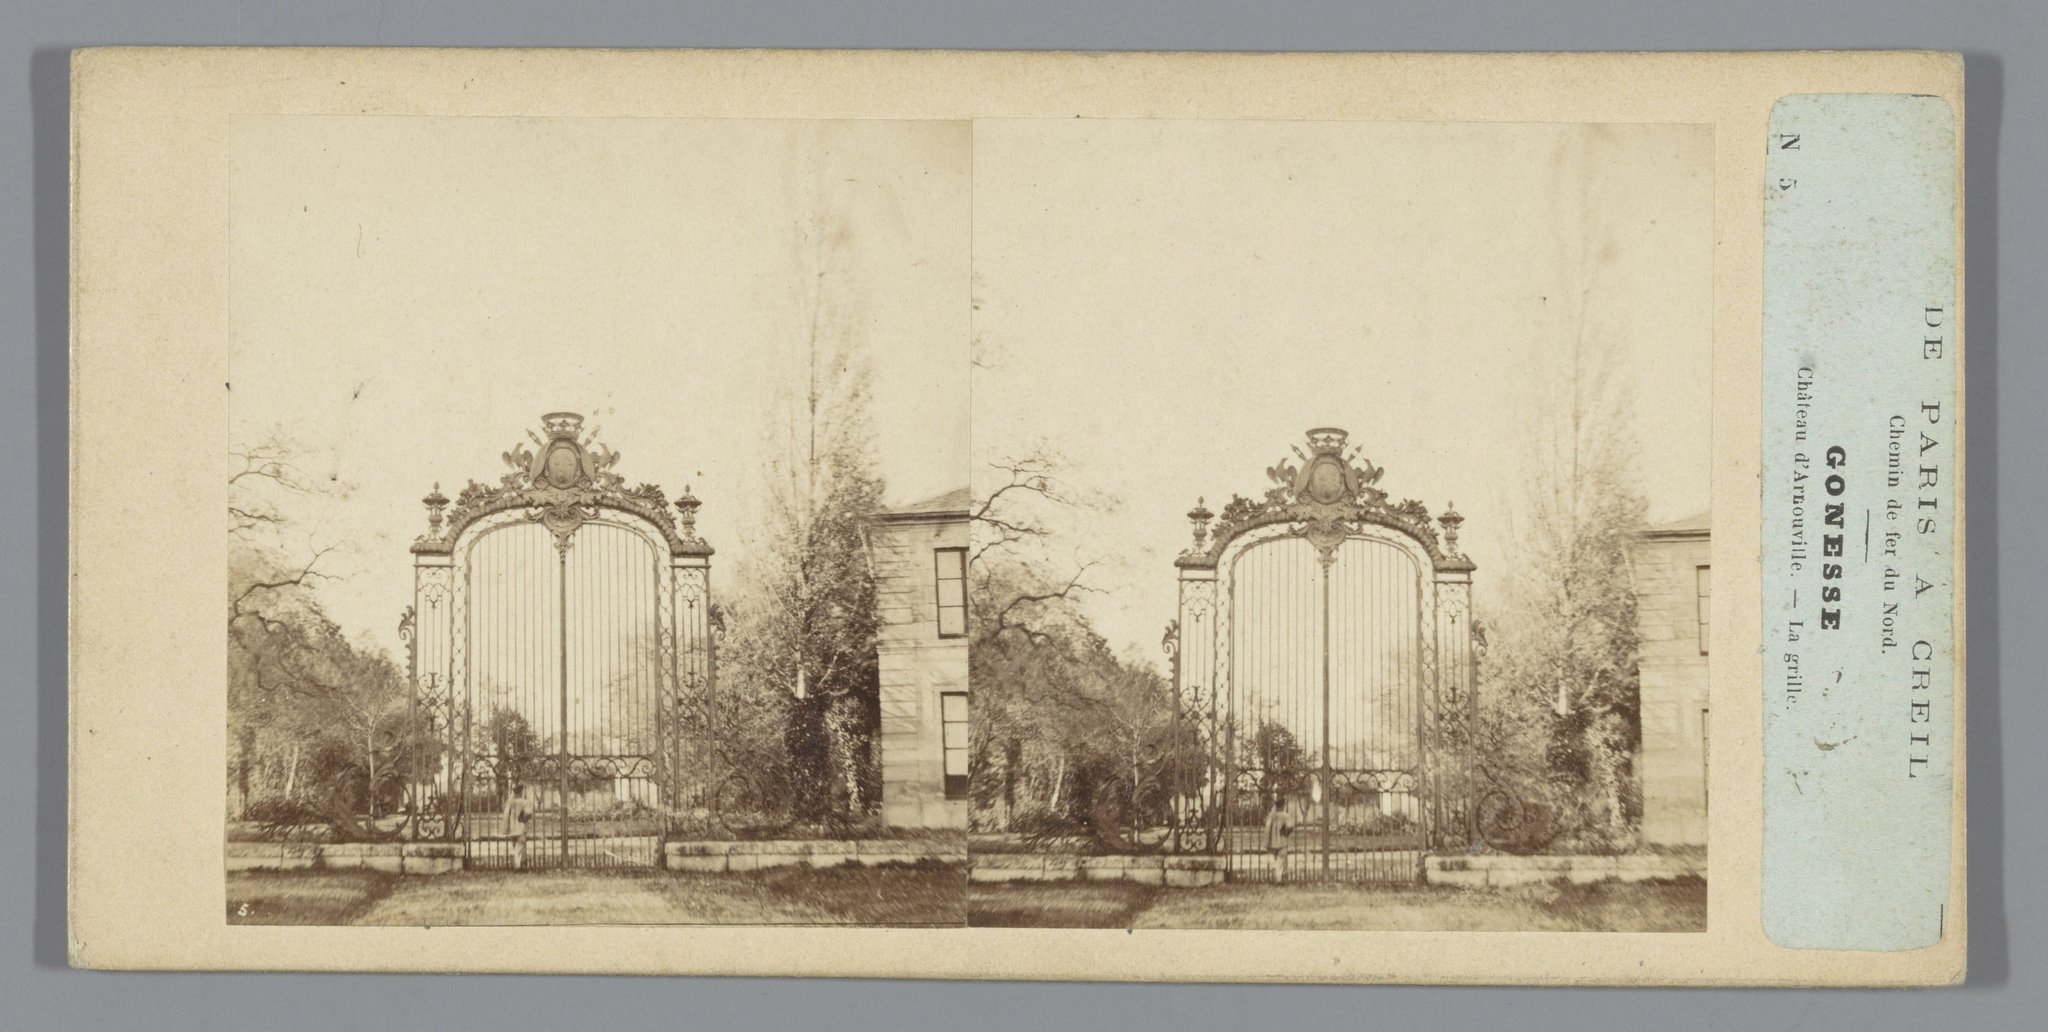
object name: stereograph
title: Toegangshek van het Château d'Arnouville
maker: Anonymous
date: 1860-1880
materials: cardboard, photographic support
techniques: albumen print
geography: arnouville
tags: fence, wall, paling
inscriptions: number: ‘N 5’, inscription: ‘Chemin de fer du Nord Villiers-Le-Bel-Gonesse (...) et le Thillay.’